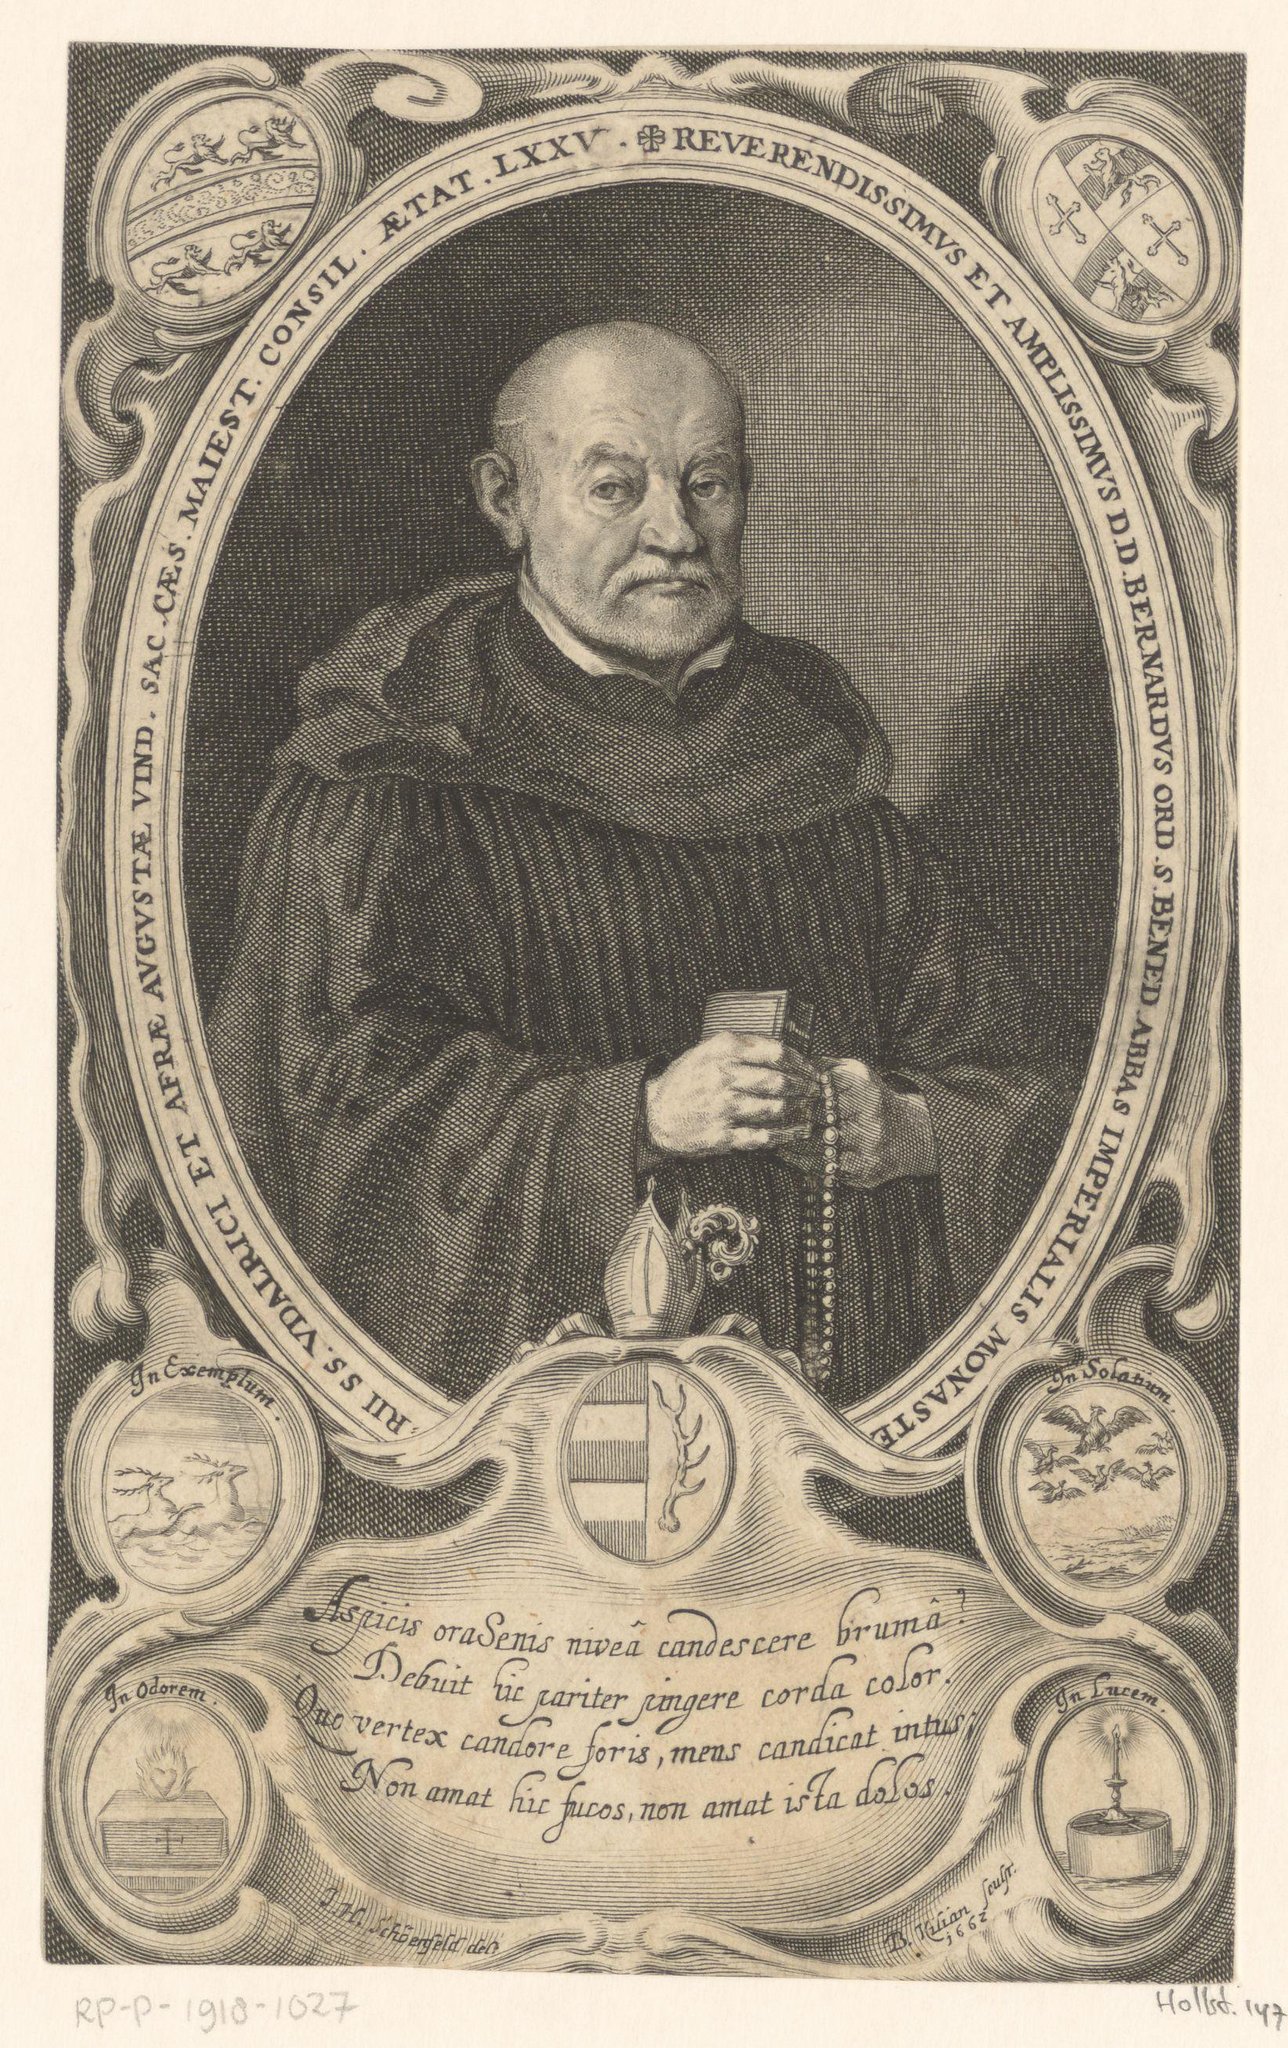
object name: print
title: Portret van Bernard Hertfelder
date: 1662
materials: paper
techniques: engraving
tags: the harlot and martyr afra of augsburg; possible attributes: dead tree, jar of ointment, stake, woodstack, historical persons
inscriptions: collector's mark: Lugt 2233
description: Geportretteerde beter bekend als monnik van de abdij Sankt Ulricht und Afra, gelegen binnen de muren van de stad Augsburg. Tekst in het Latijn in de omlijsting van het medaillon en onderaan op de sokkel.